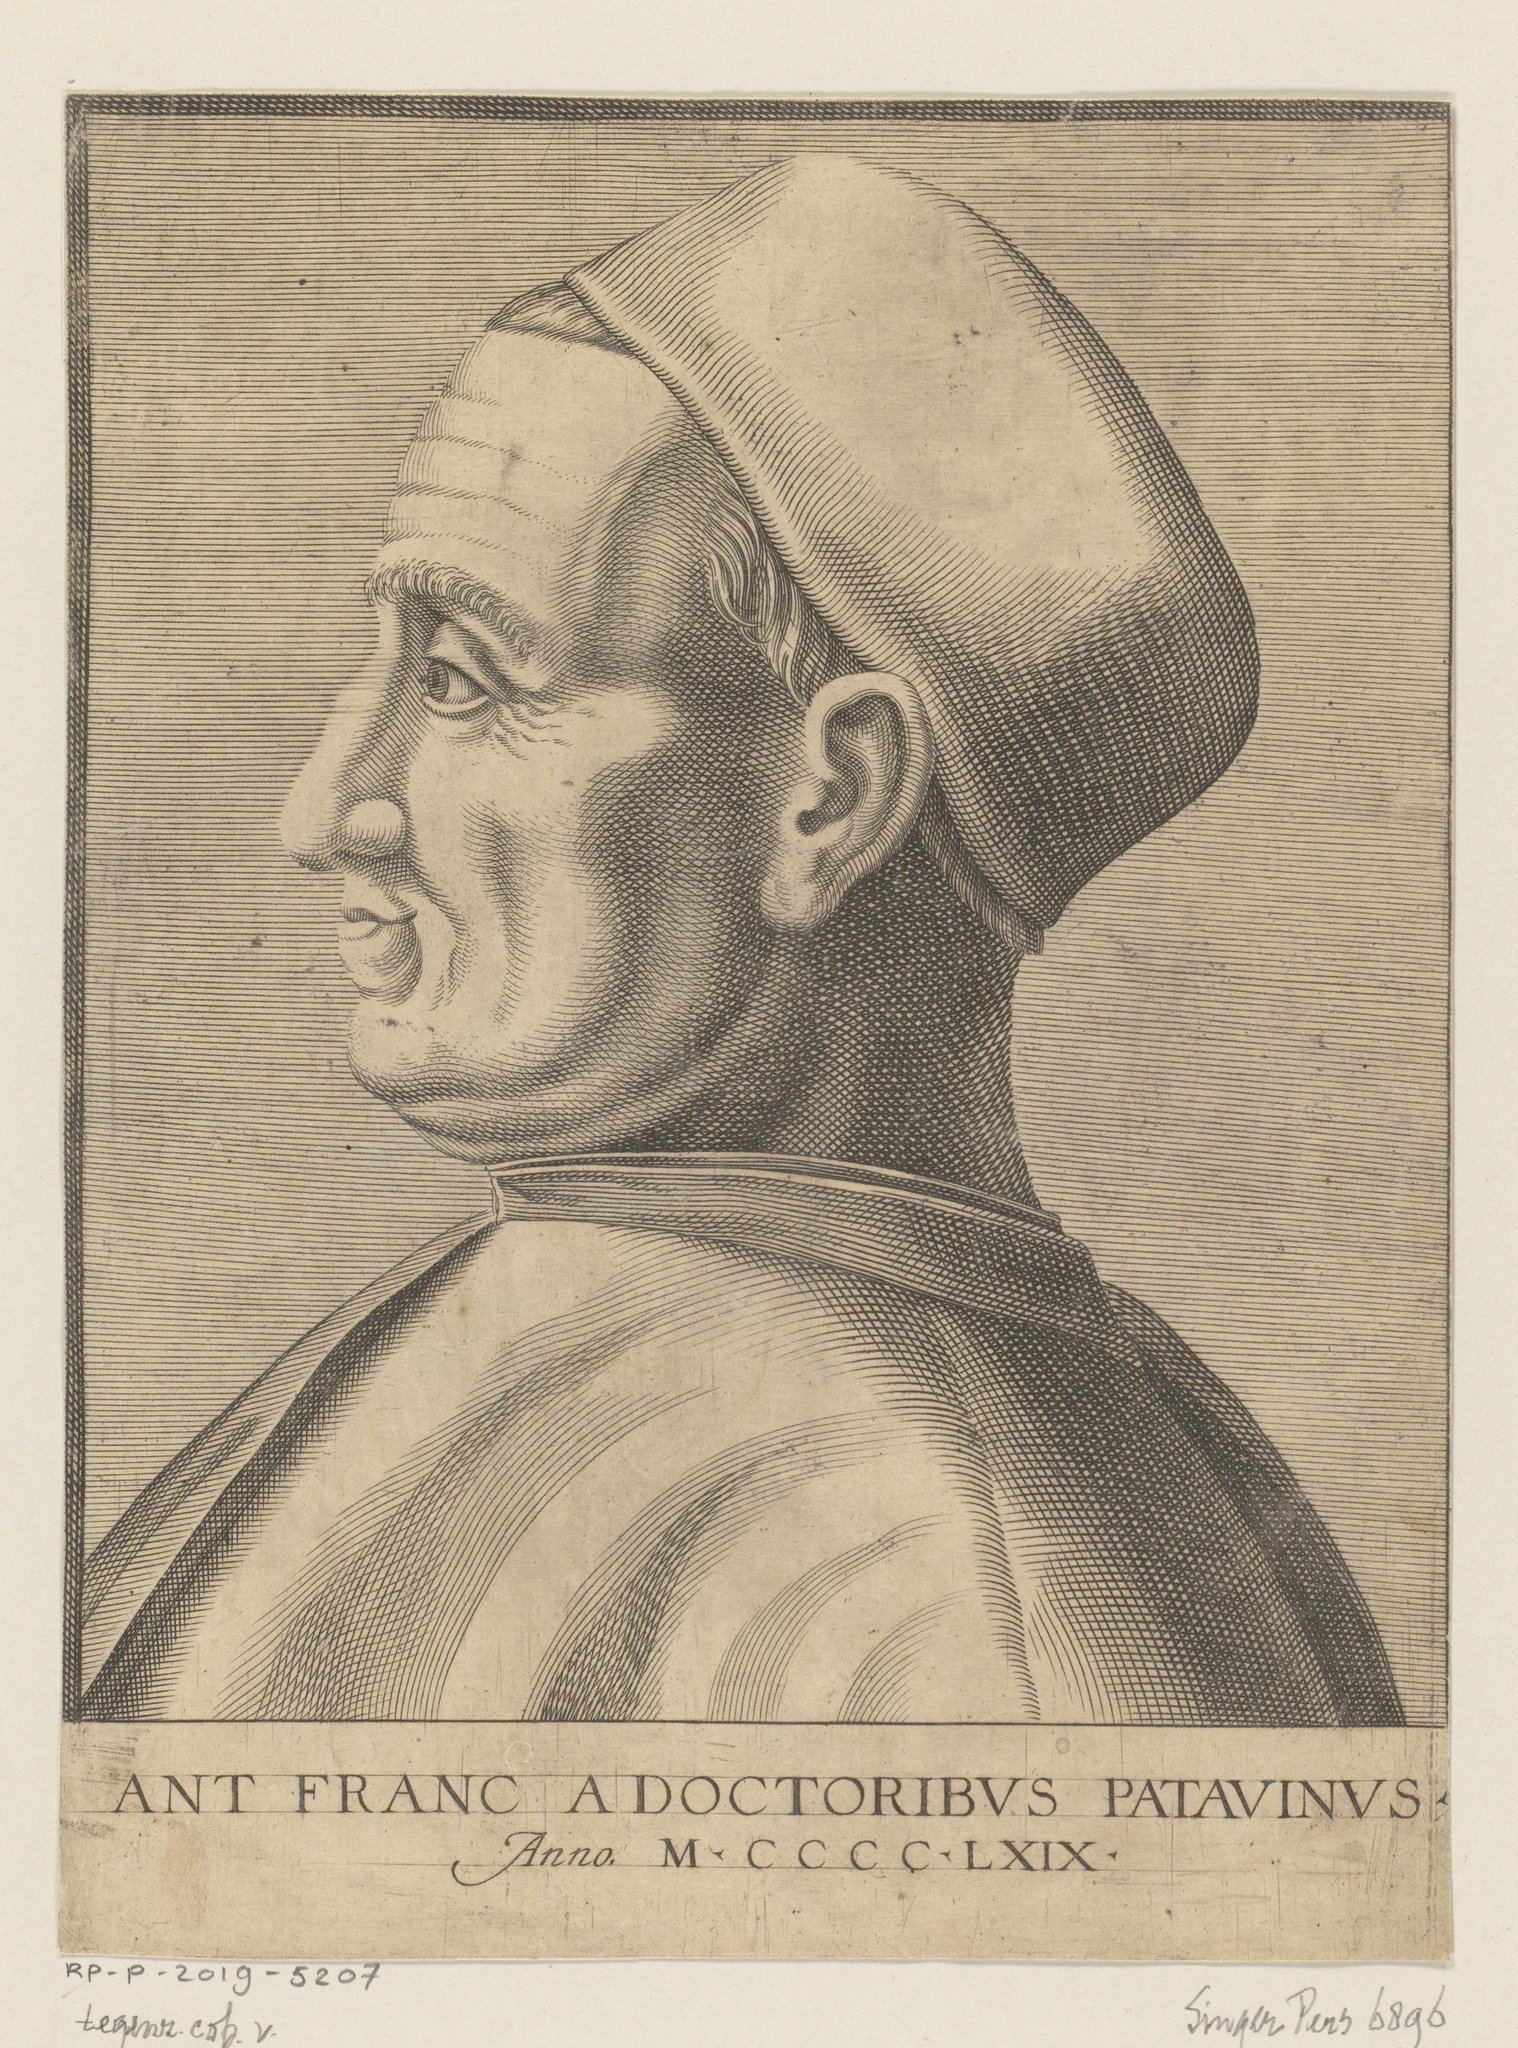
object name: print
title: Portret van Antonio Francesco Dottori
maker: Anonymous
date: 1566-1599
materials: paper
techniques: engraving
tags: historical persons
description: Kopie (gespiegeld) naar prent uit: Benavides, Marco Mantova. Illustrium jureconsultorum imagines quae inveniri potuerunt ad vivam effigiem expressae (...). Rome: Antonio Lafreri, 1566.